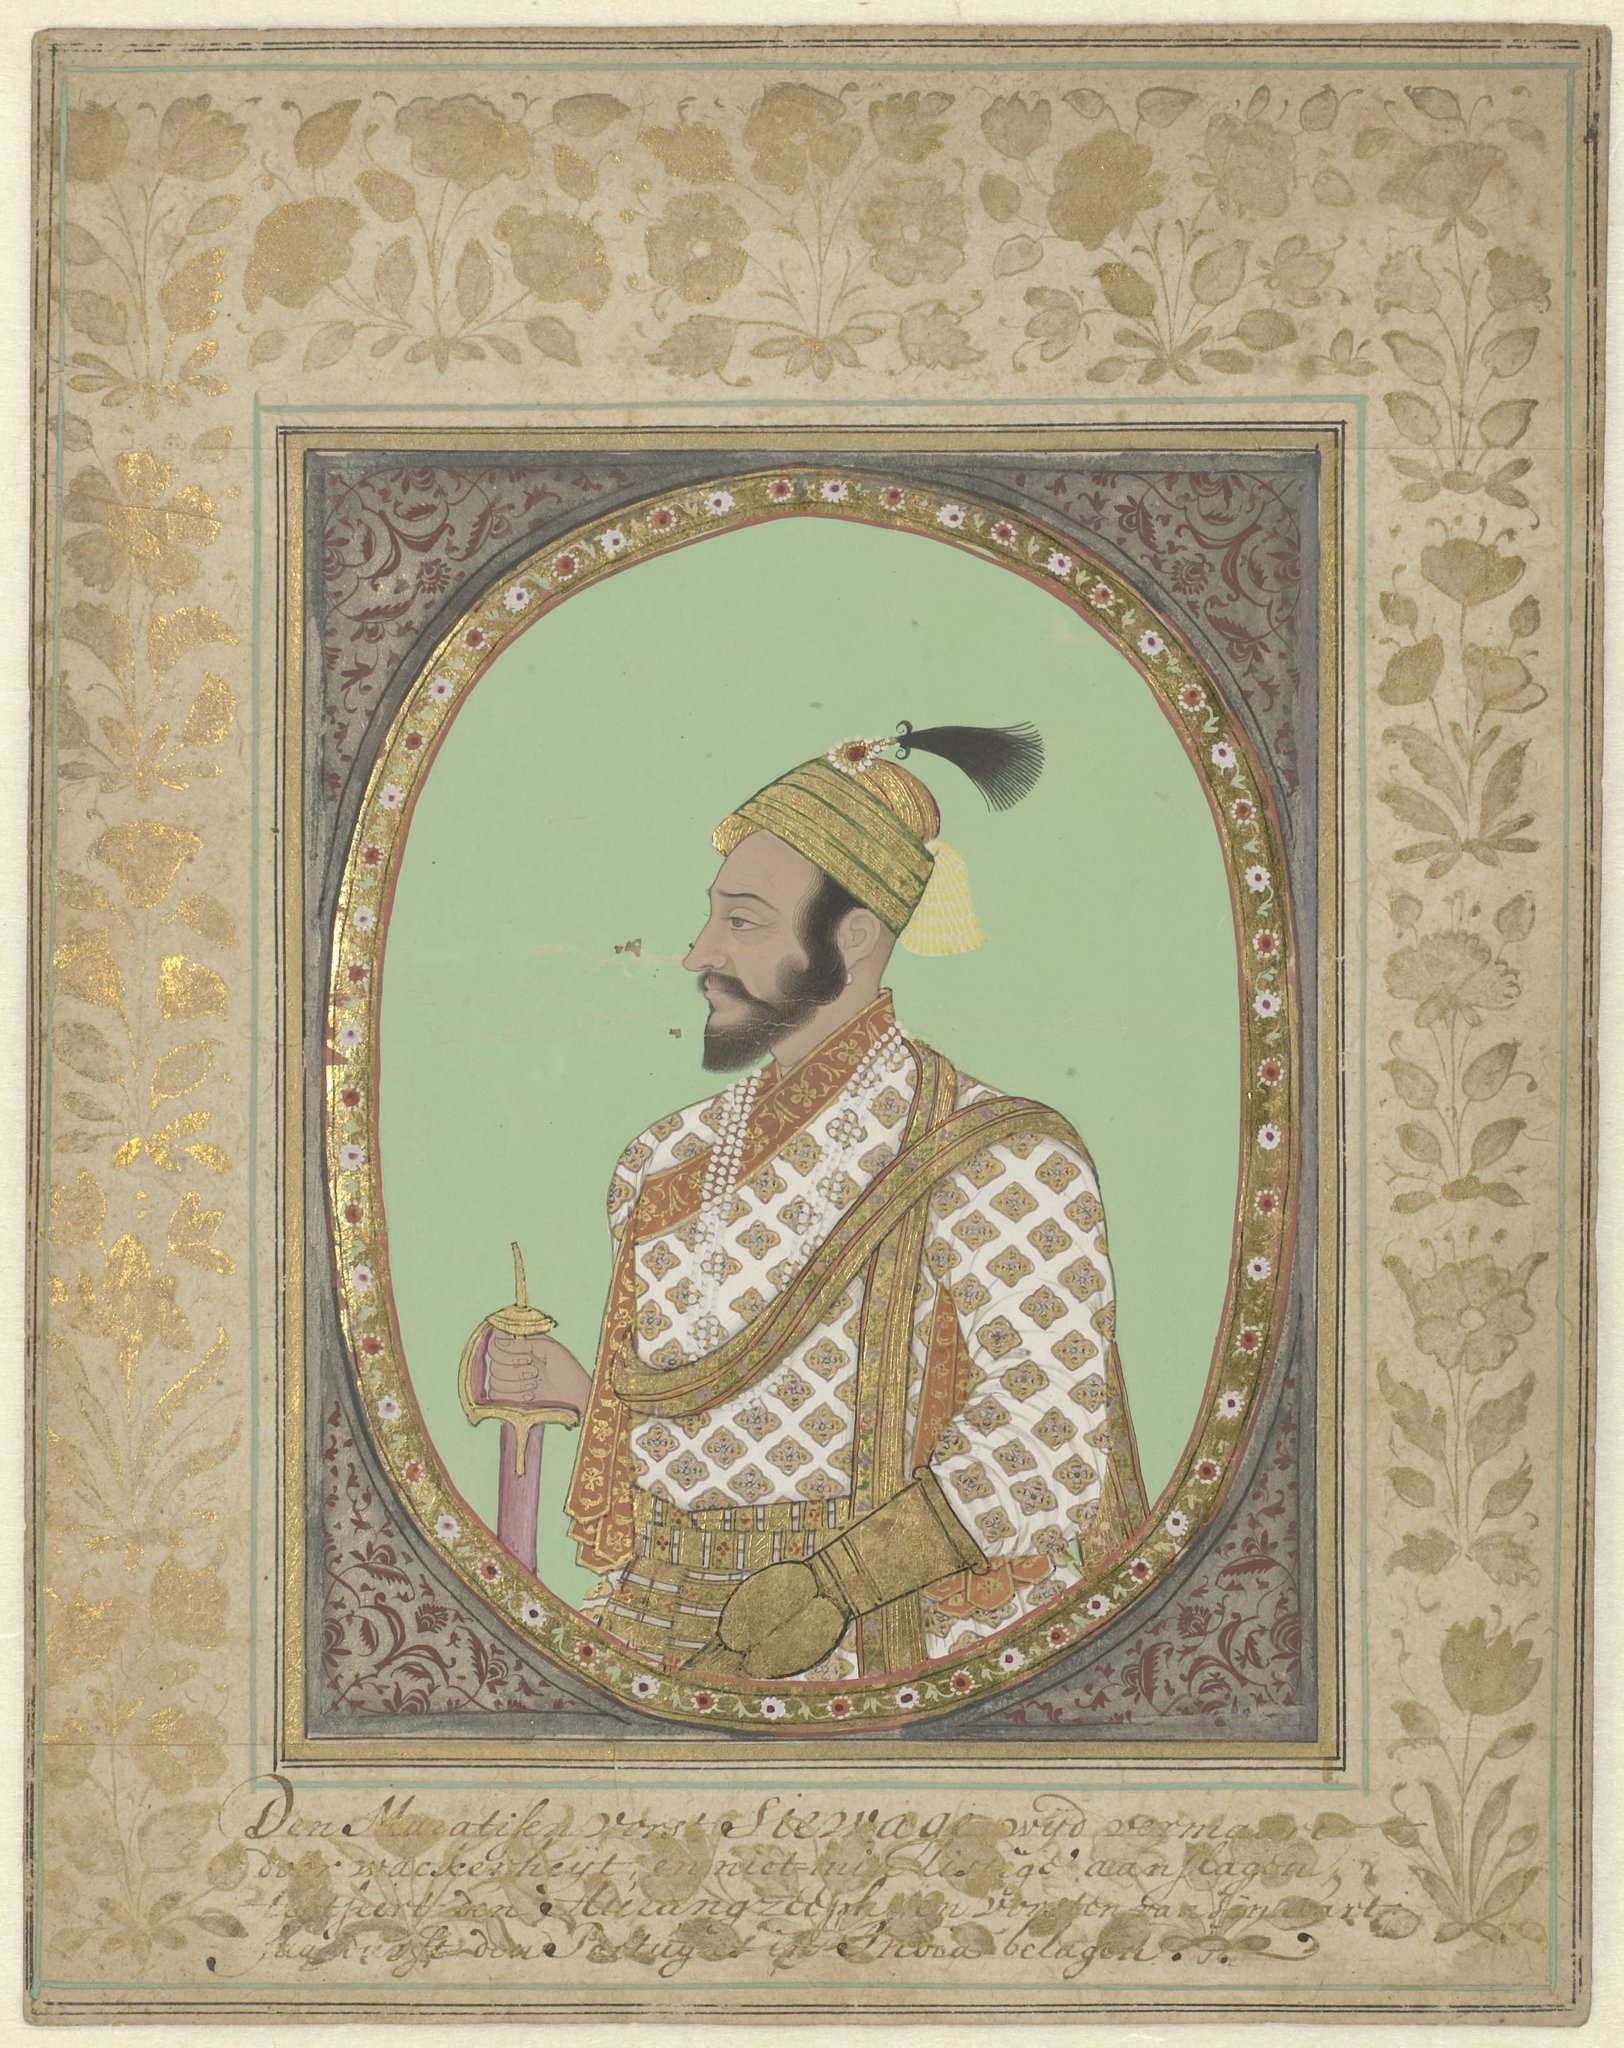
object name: indian miniature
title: Portret van Maratha vorst Shivaji met uitvoerig Hollands onderschrift op de versierde omlijsting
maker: Anonymous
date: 1680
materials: paint, gouache, paper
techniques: brush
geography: golkonda